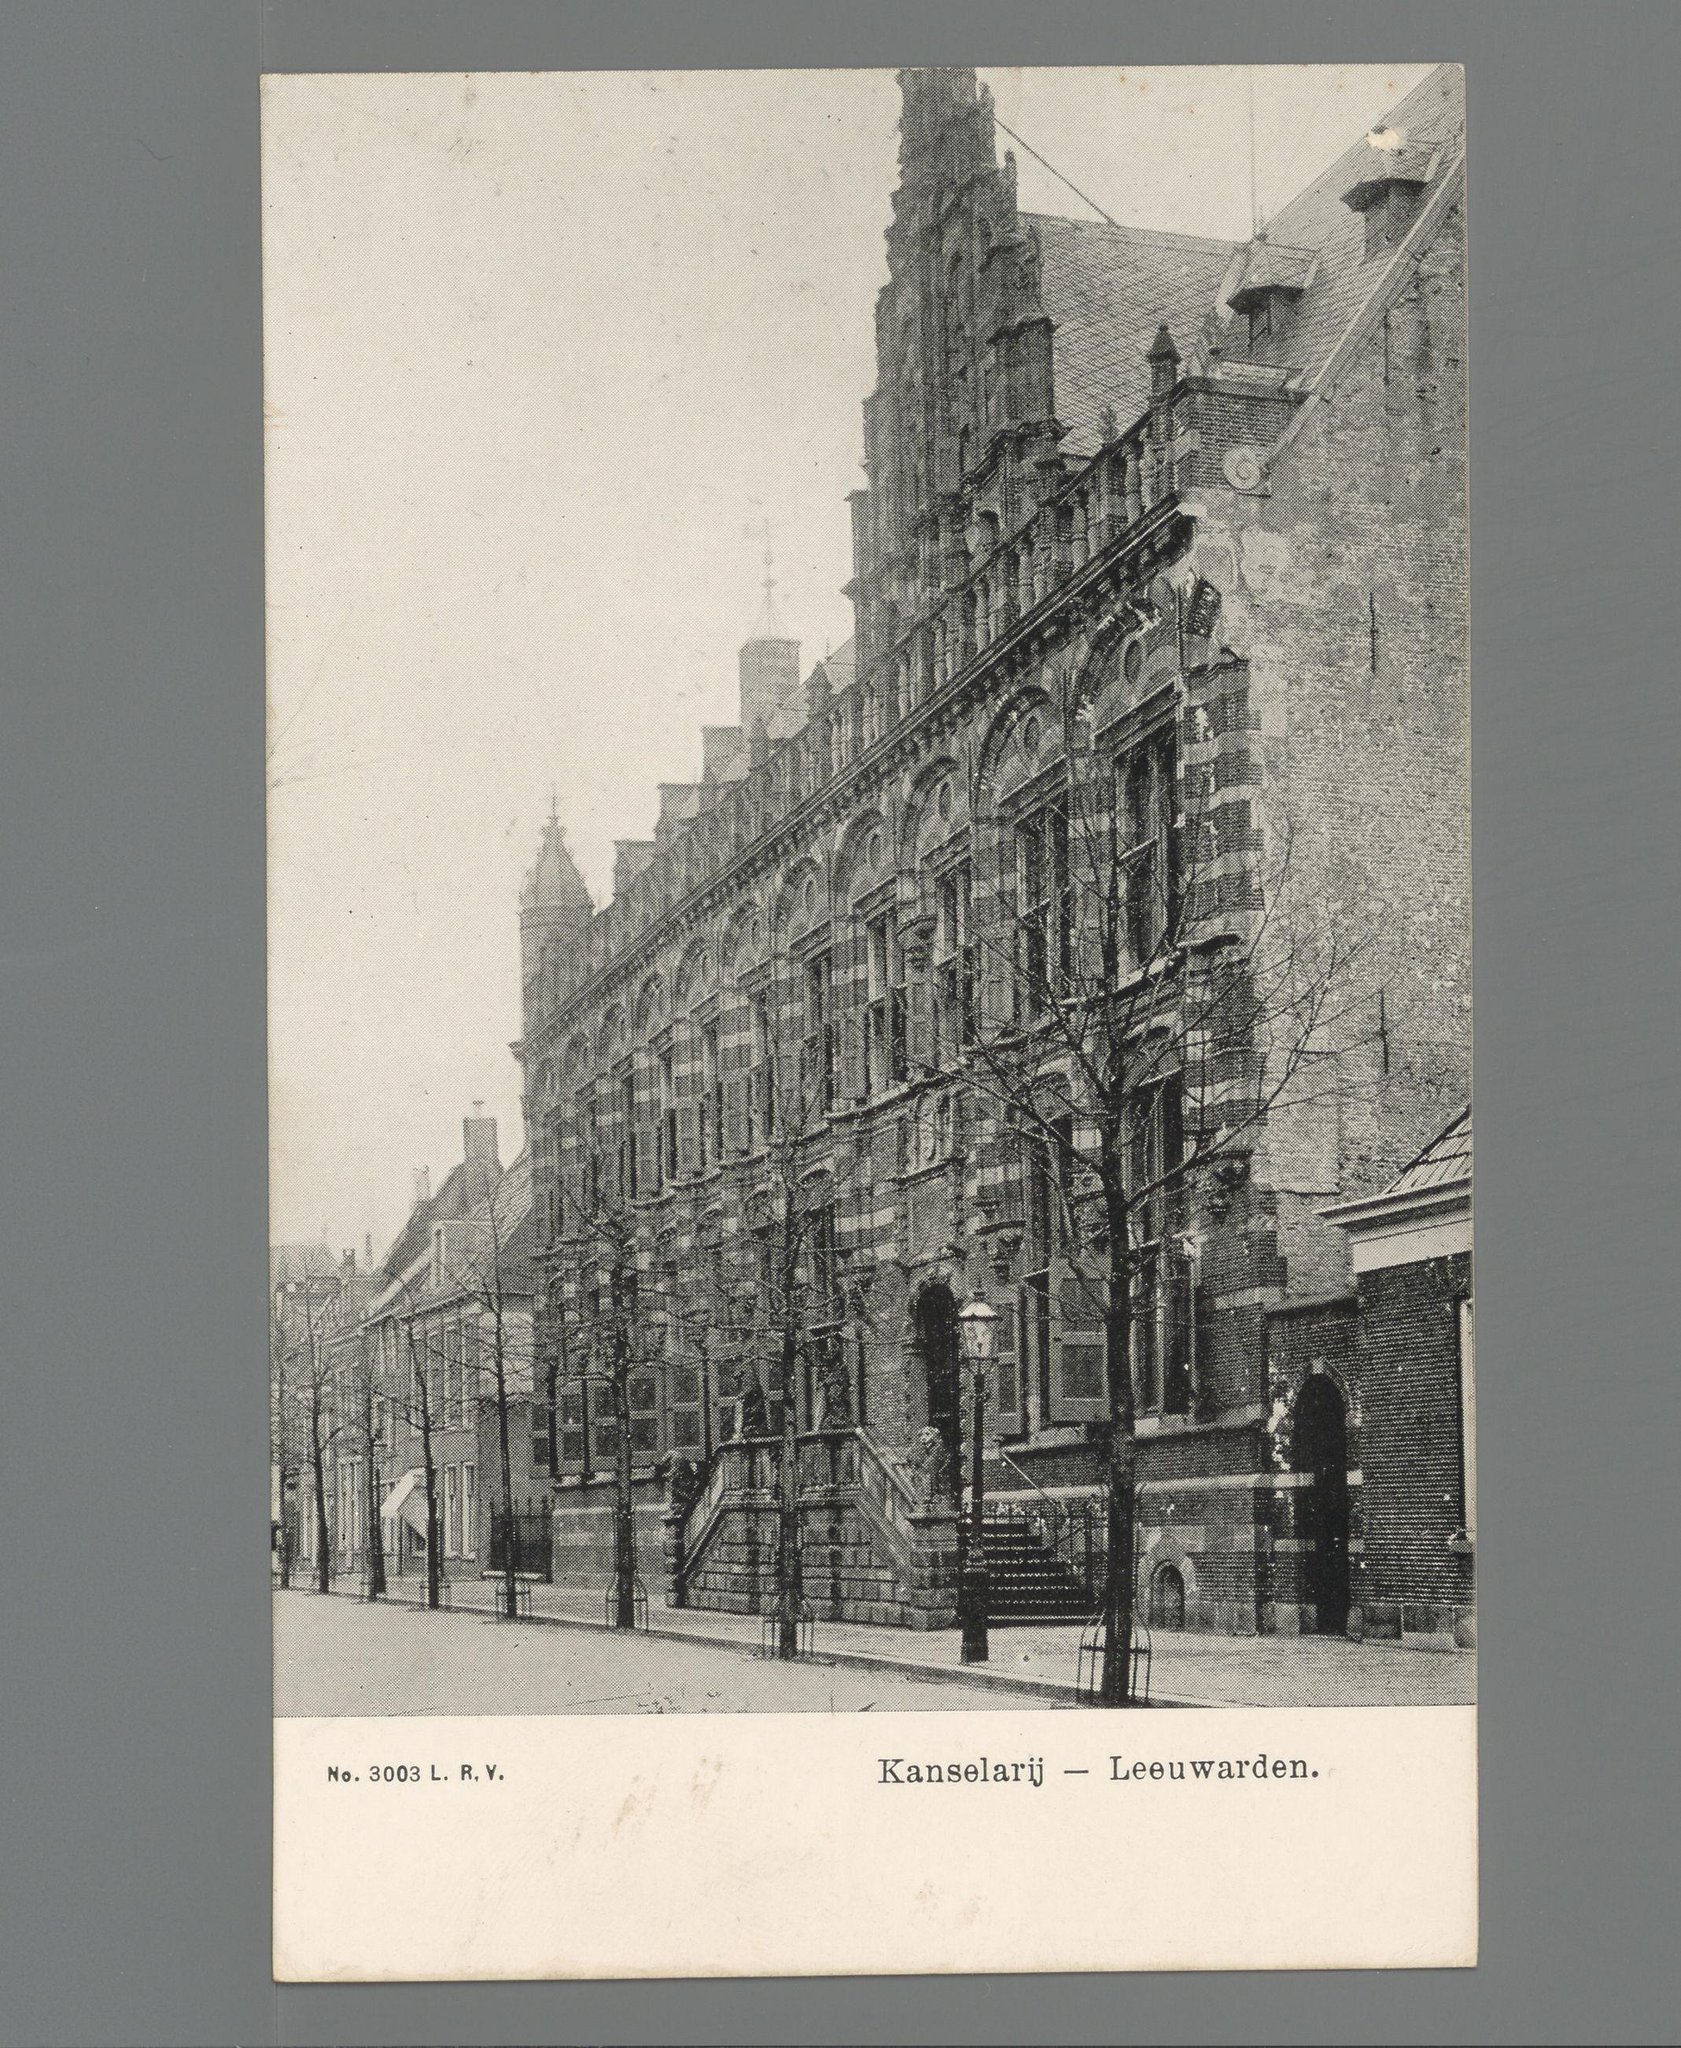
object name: ansichtkaart, prentbriefkaart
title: Kanselarij - Leeuwarden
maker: Anonymous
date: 1905-1930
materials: cardboard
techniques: autotype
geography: zwolle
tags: façade (of house or building), street